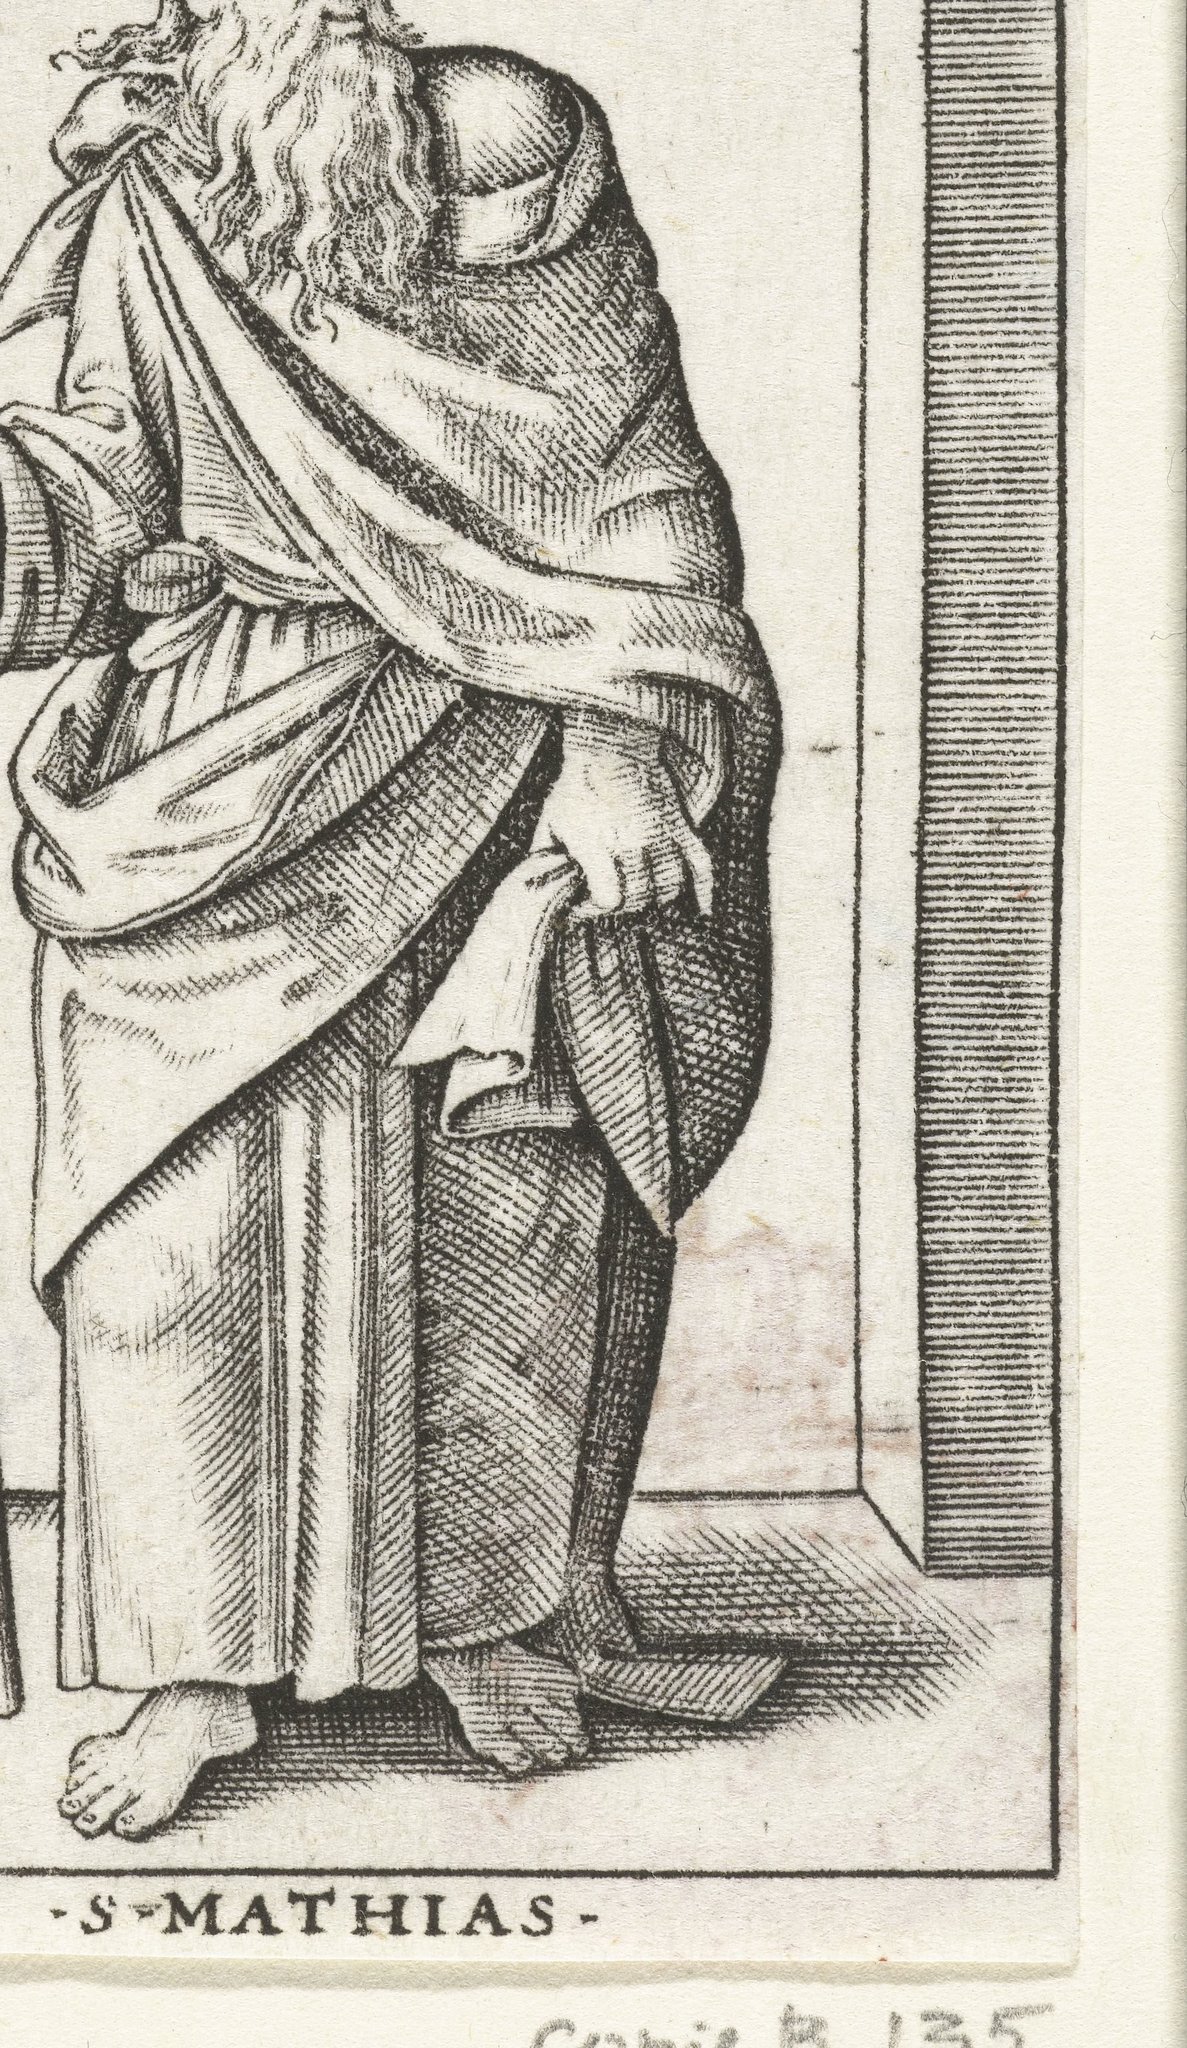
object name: print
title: Apostel Mattias met speer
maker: Anonymous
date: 1517-1577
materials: paper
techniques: engraving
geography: italy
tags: the apostle and martyr matthias; possible attributes: axe, book, cross, halberd, scroll, sword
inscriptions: collector's mark: Lugt 12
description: Kopie naar prent van Marcantonio Raimondi. Raimondi vervaardigde een serie van dertien kleine prenten met Christus en de apostelen naar ontwerp van Raphael.